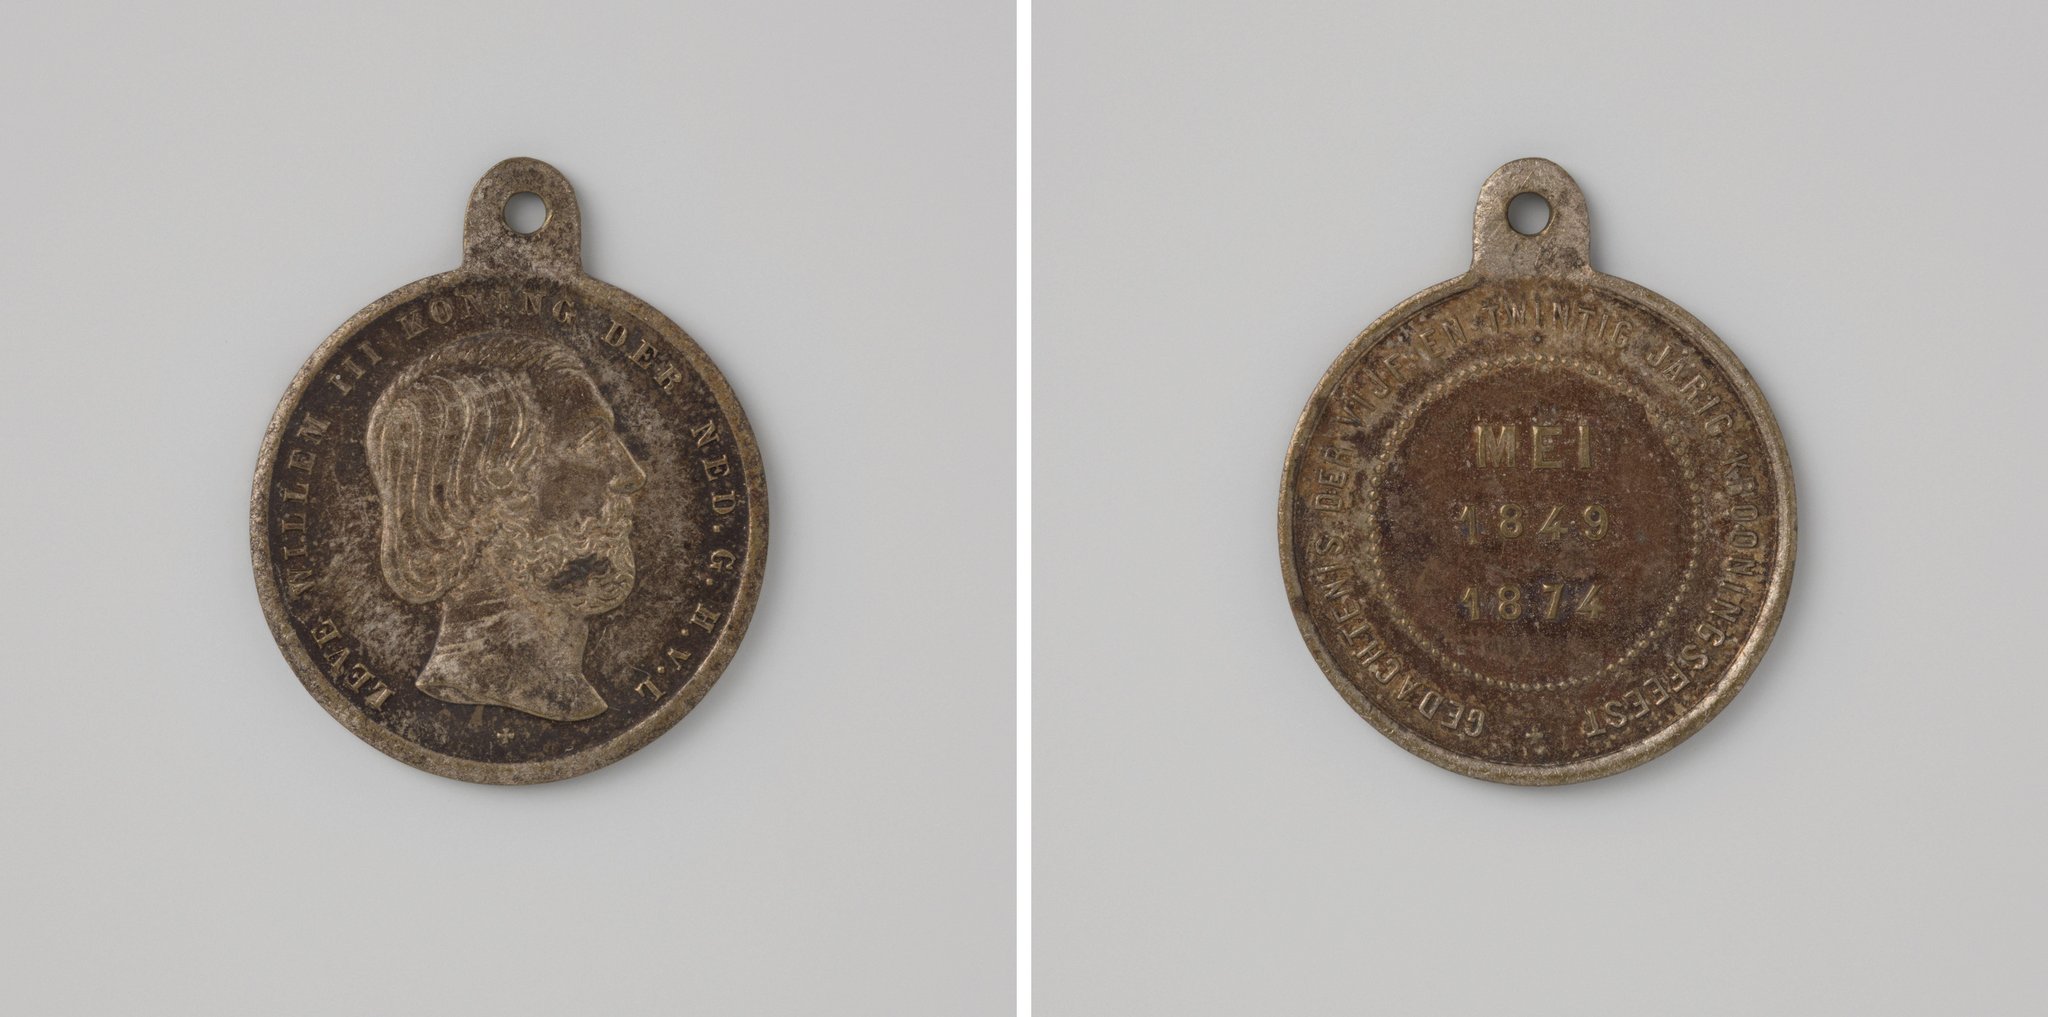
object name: history medal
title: Vijfentwintigjarig regeringsjubileum van Koning Willem III 1874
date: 1874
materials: brass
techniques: striking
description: Verzilverd messing penninkje met draagoog, op de voorzijde het portret van Willem III naar rechts met omschrift, op de keerzijde drie regels tekst met omschrift.